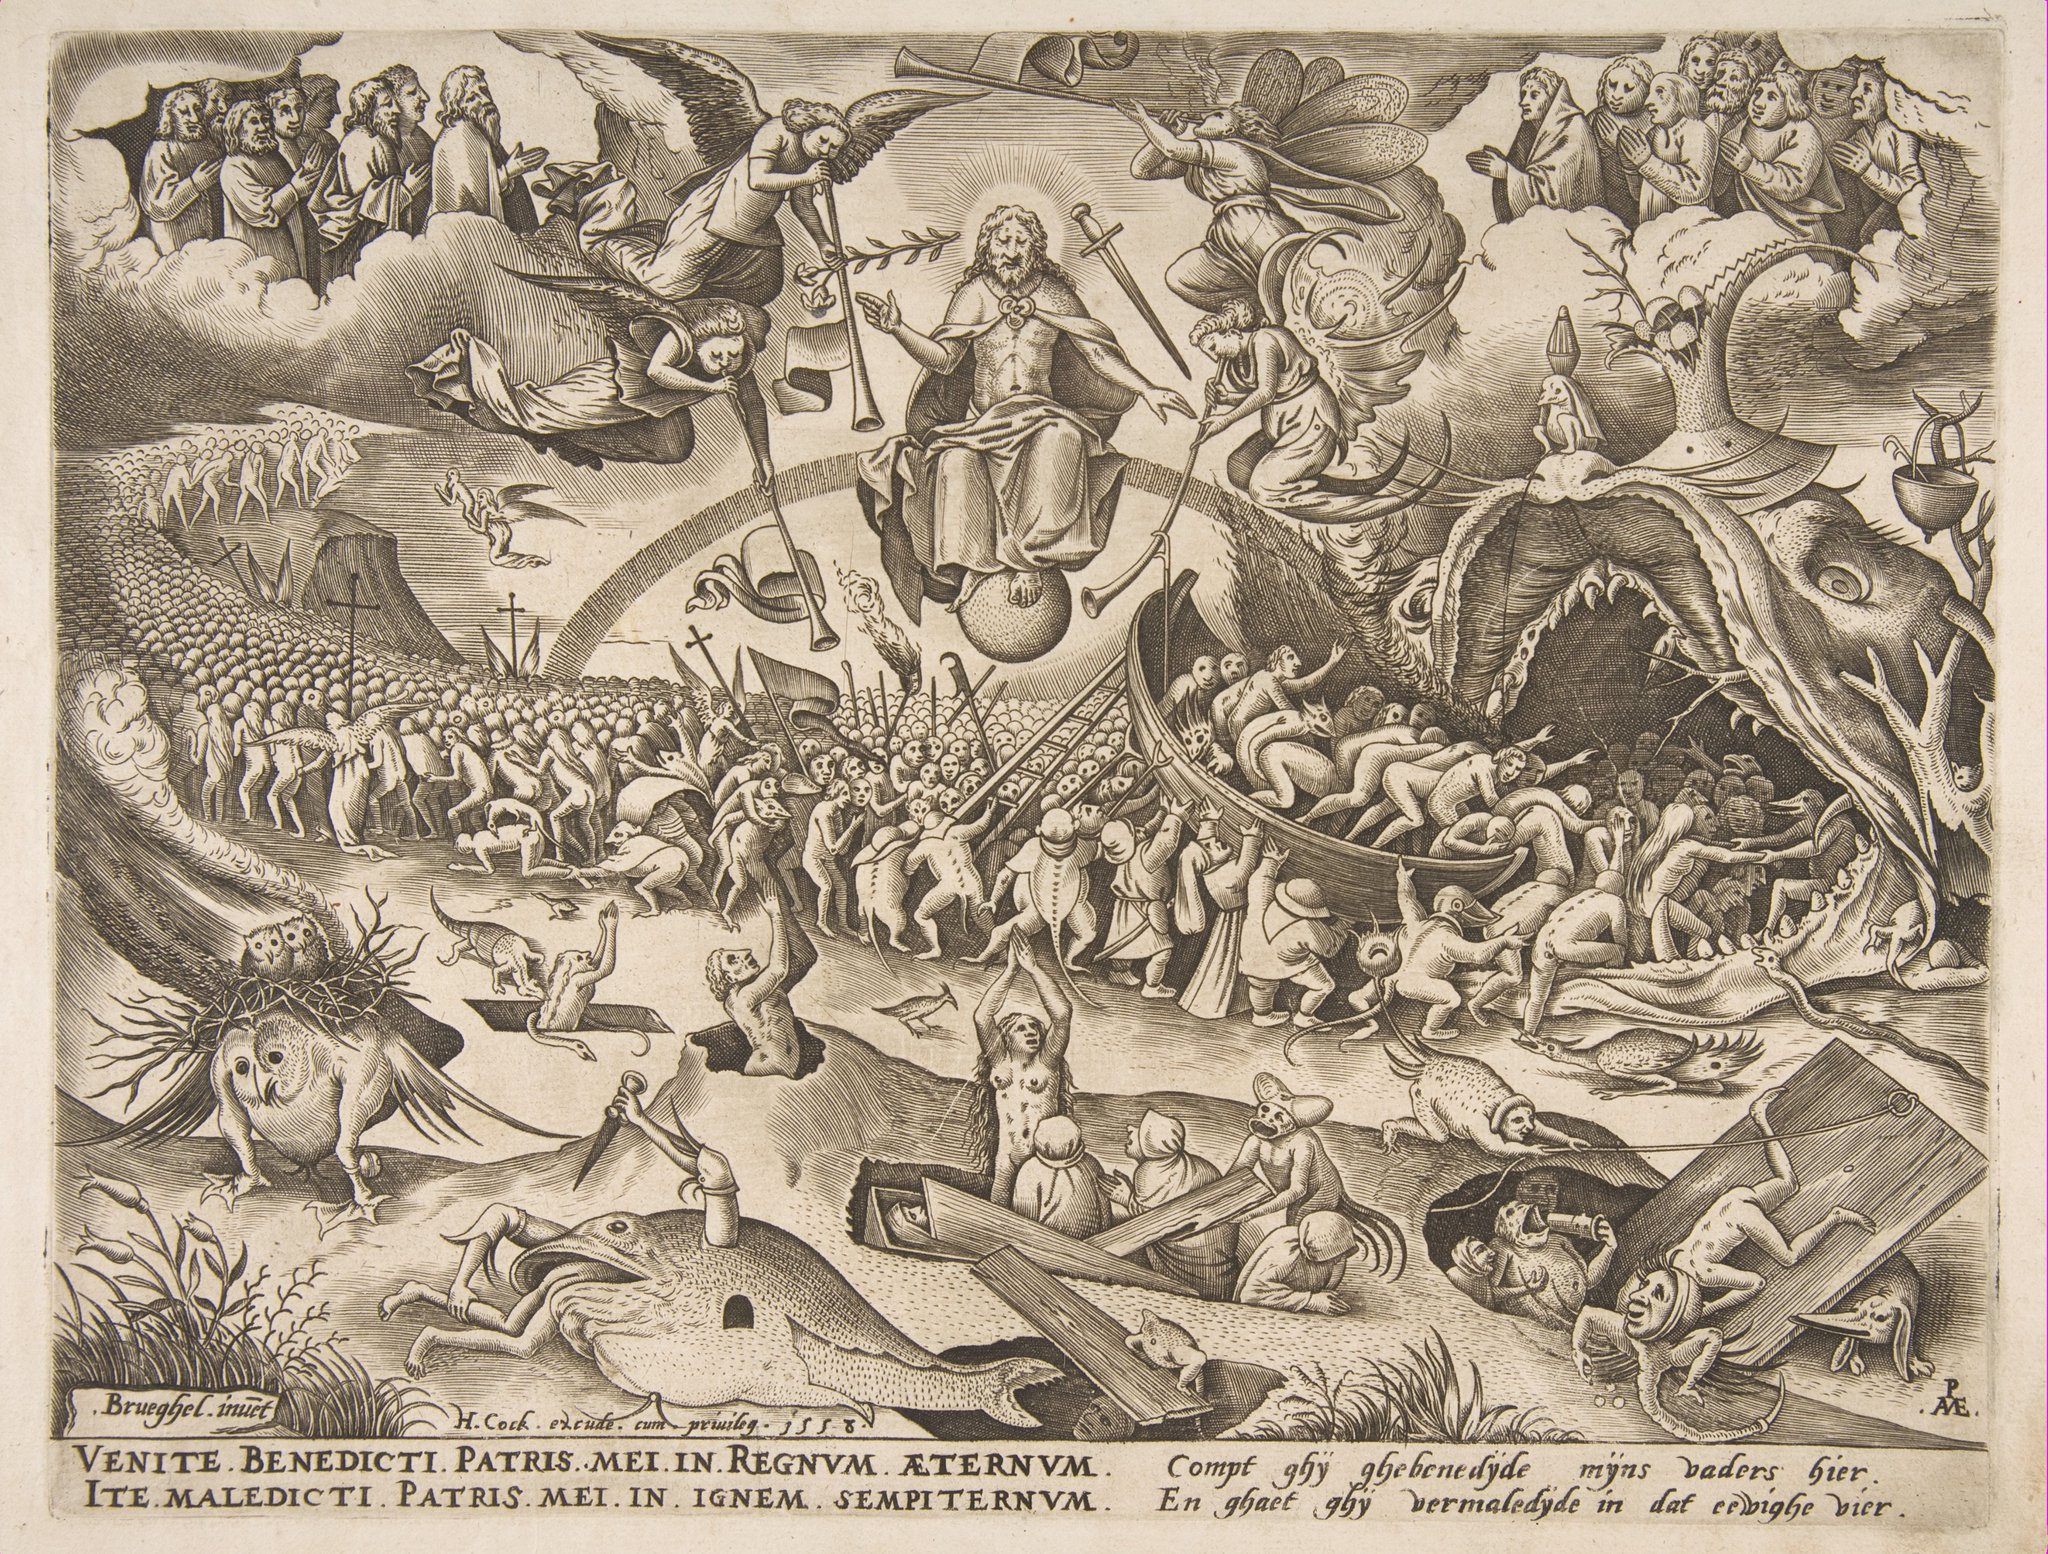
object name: print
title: The Last Judgment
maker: pieter bruegel the elder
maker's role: artist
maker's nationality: netherlandish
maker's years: 1525-1569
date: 1558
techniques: engraving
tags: last judgement